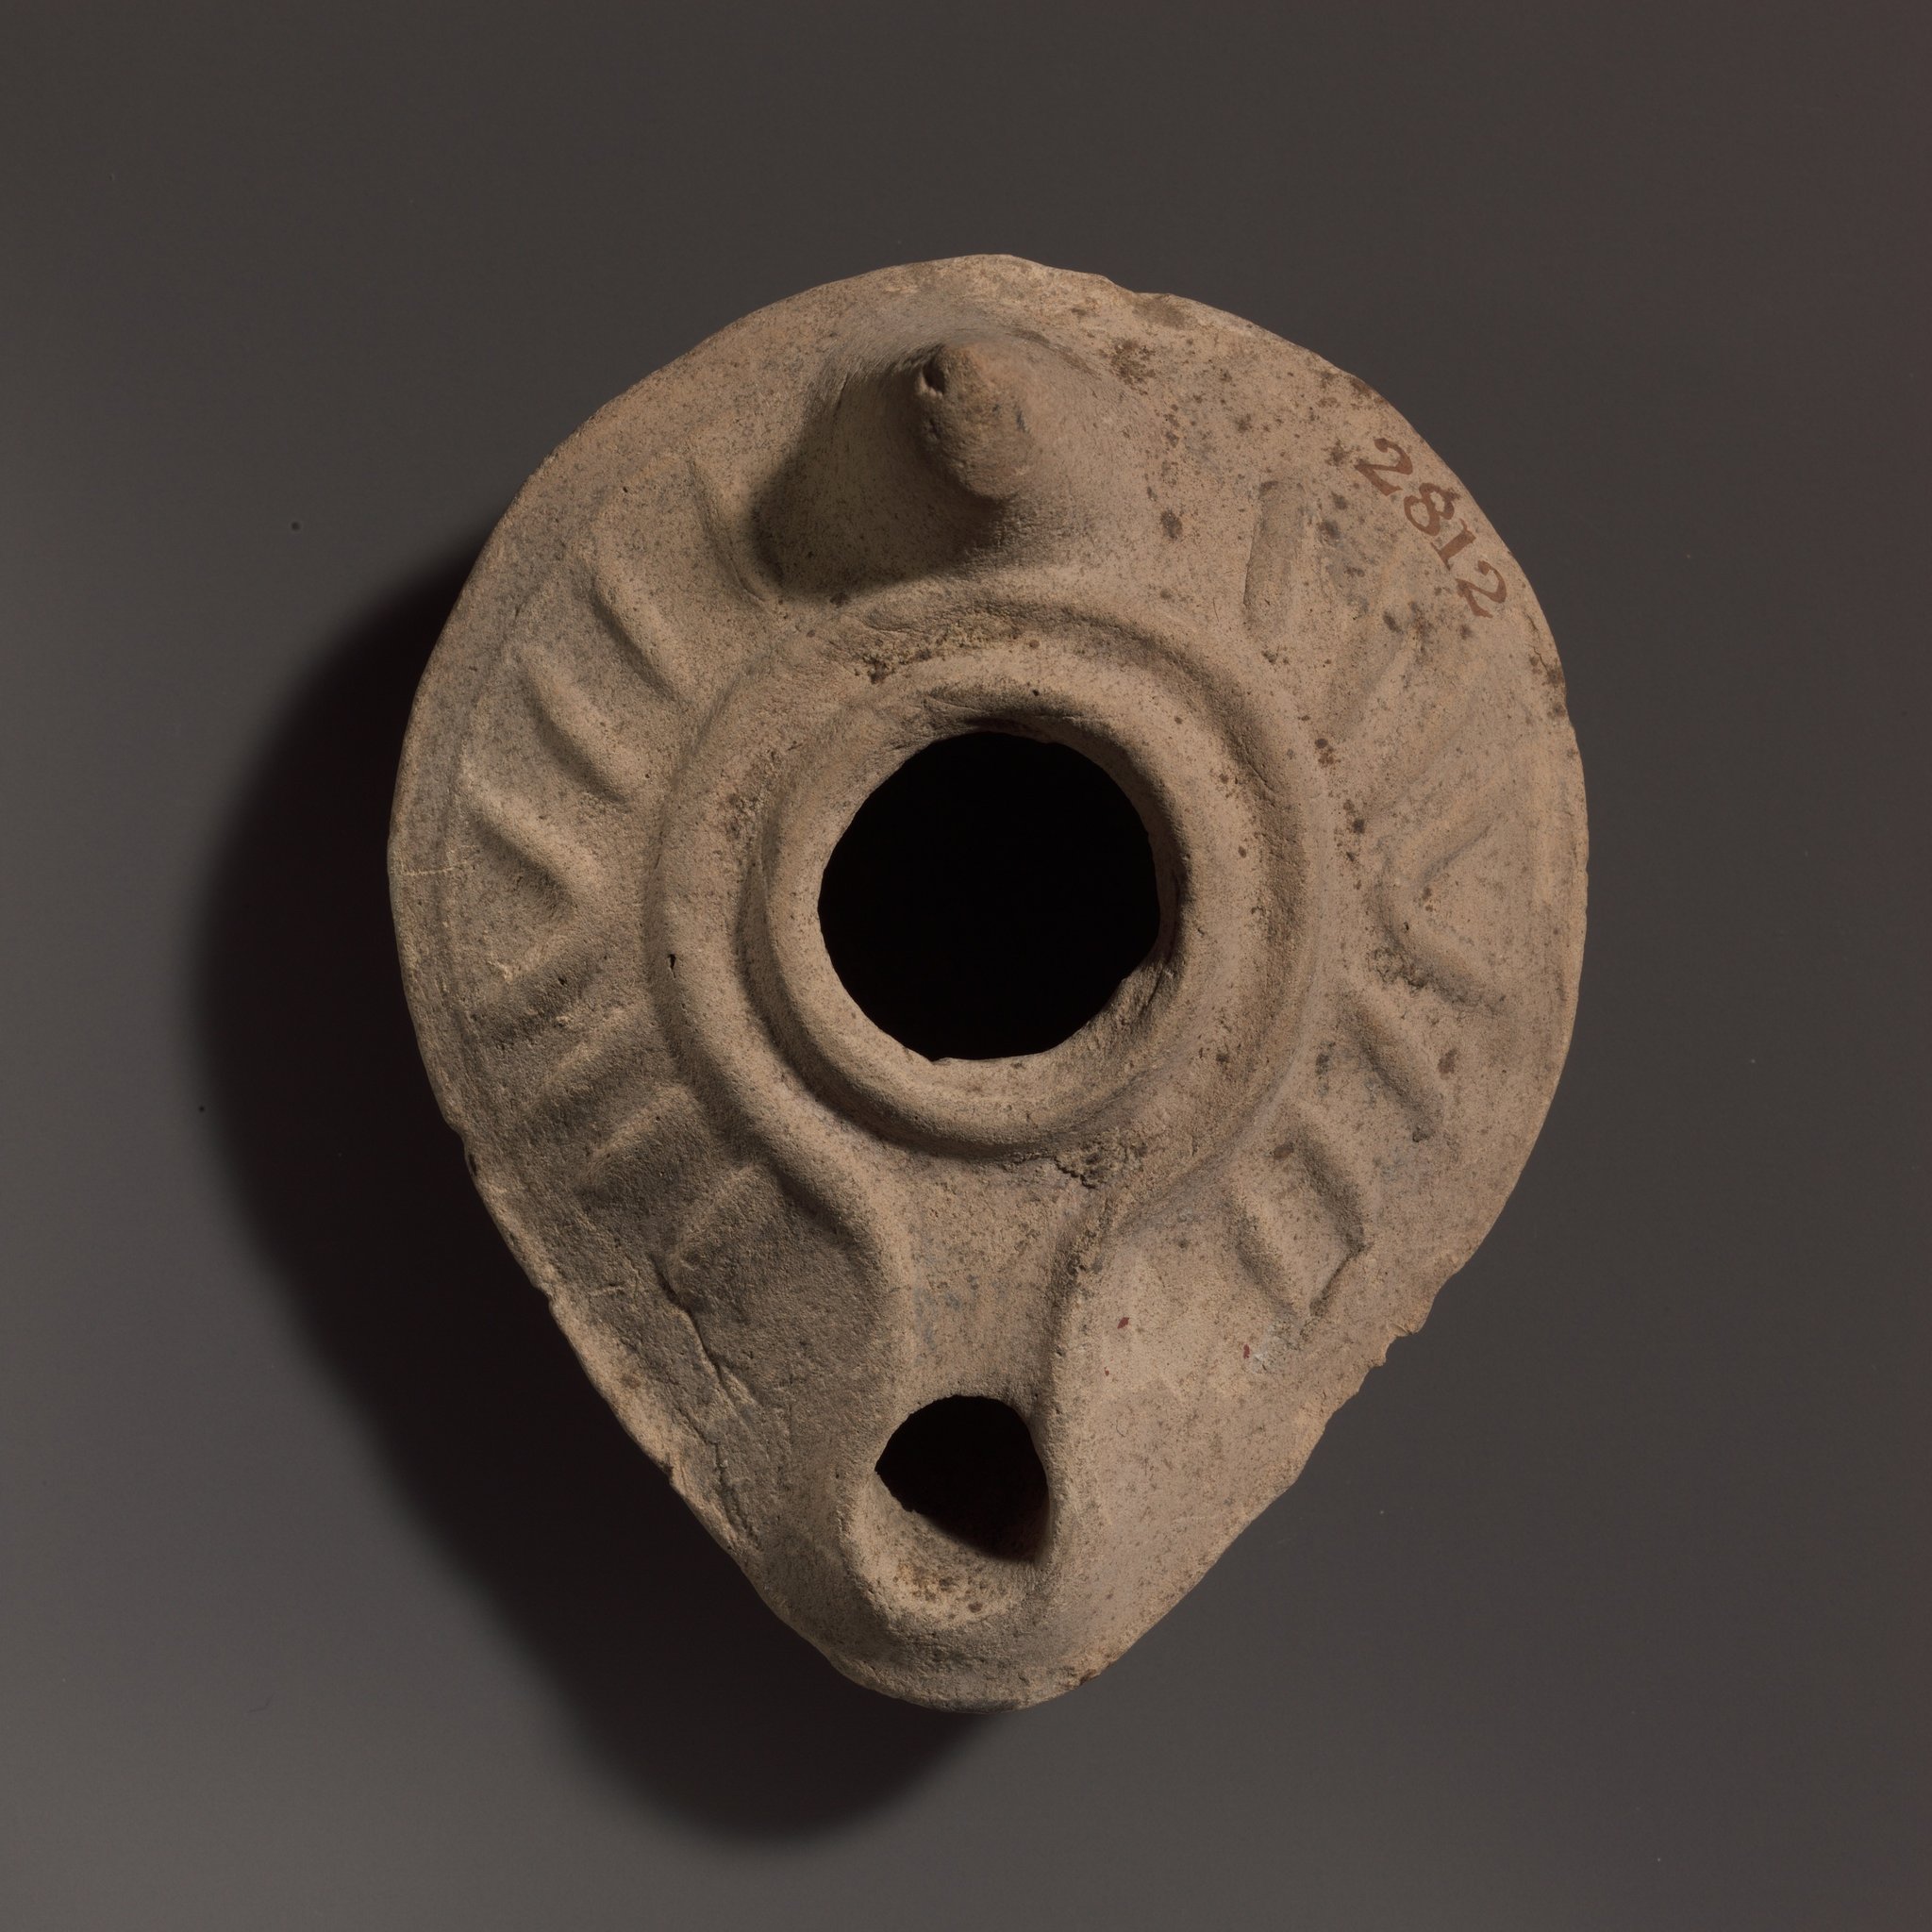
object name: lamp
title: Terracotta oil lamp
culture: roman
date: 601-700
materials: terracotta